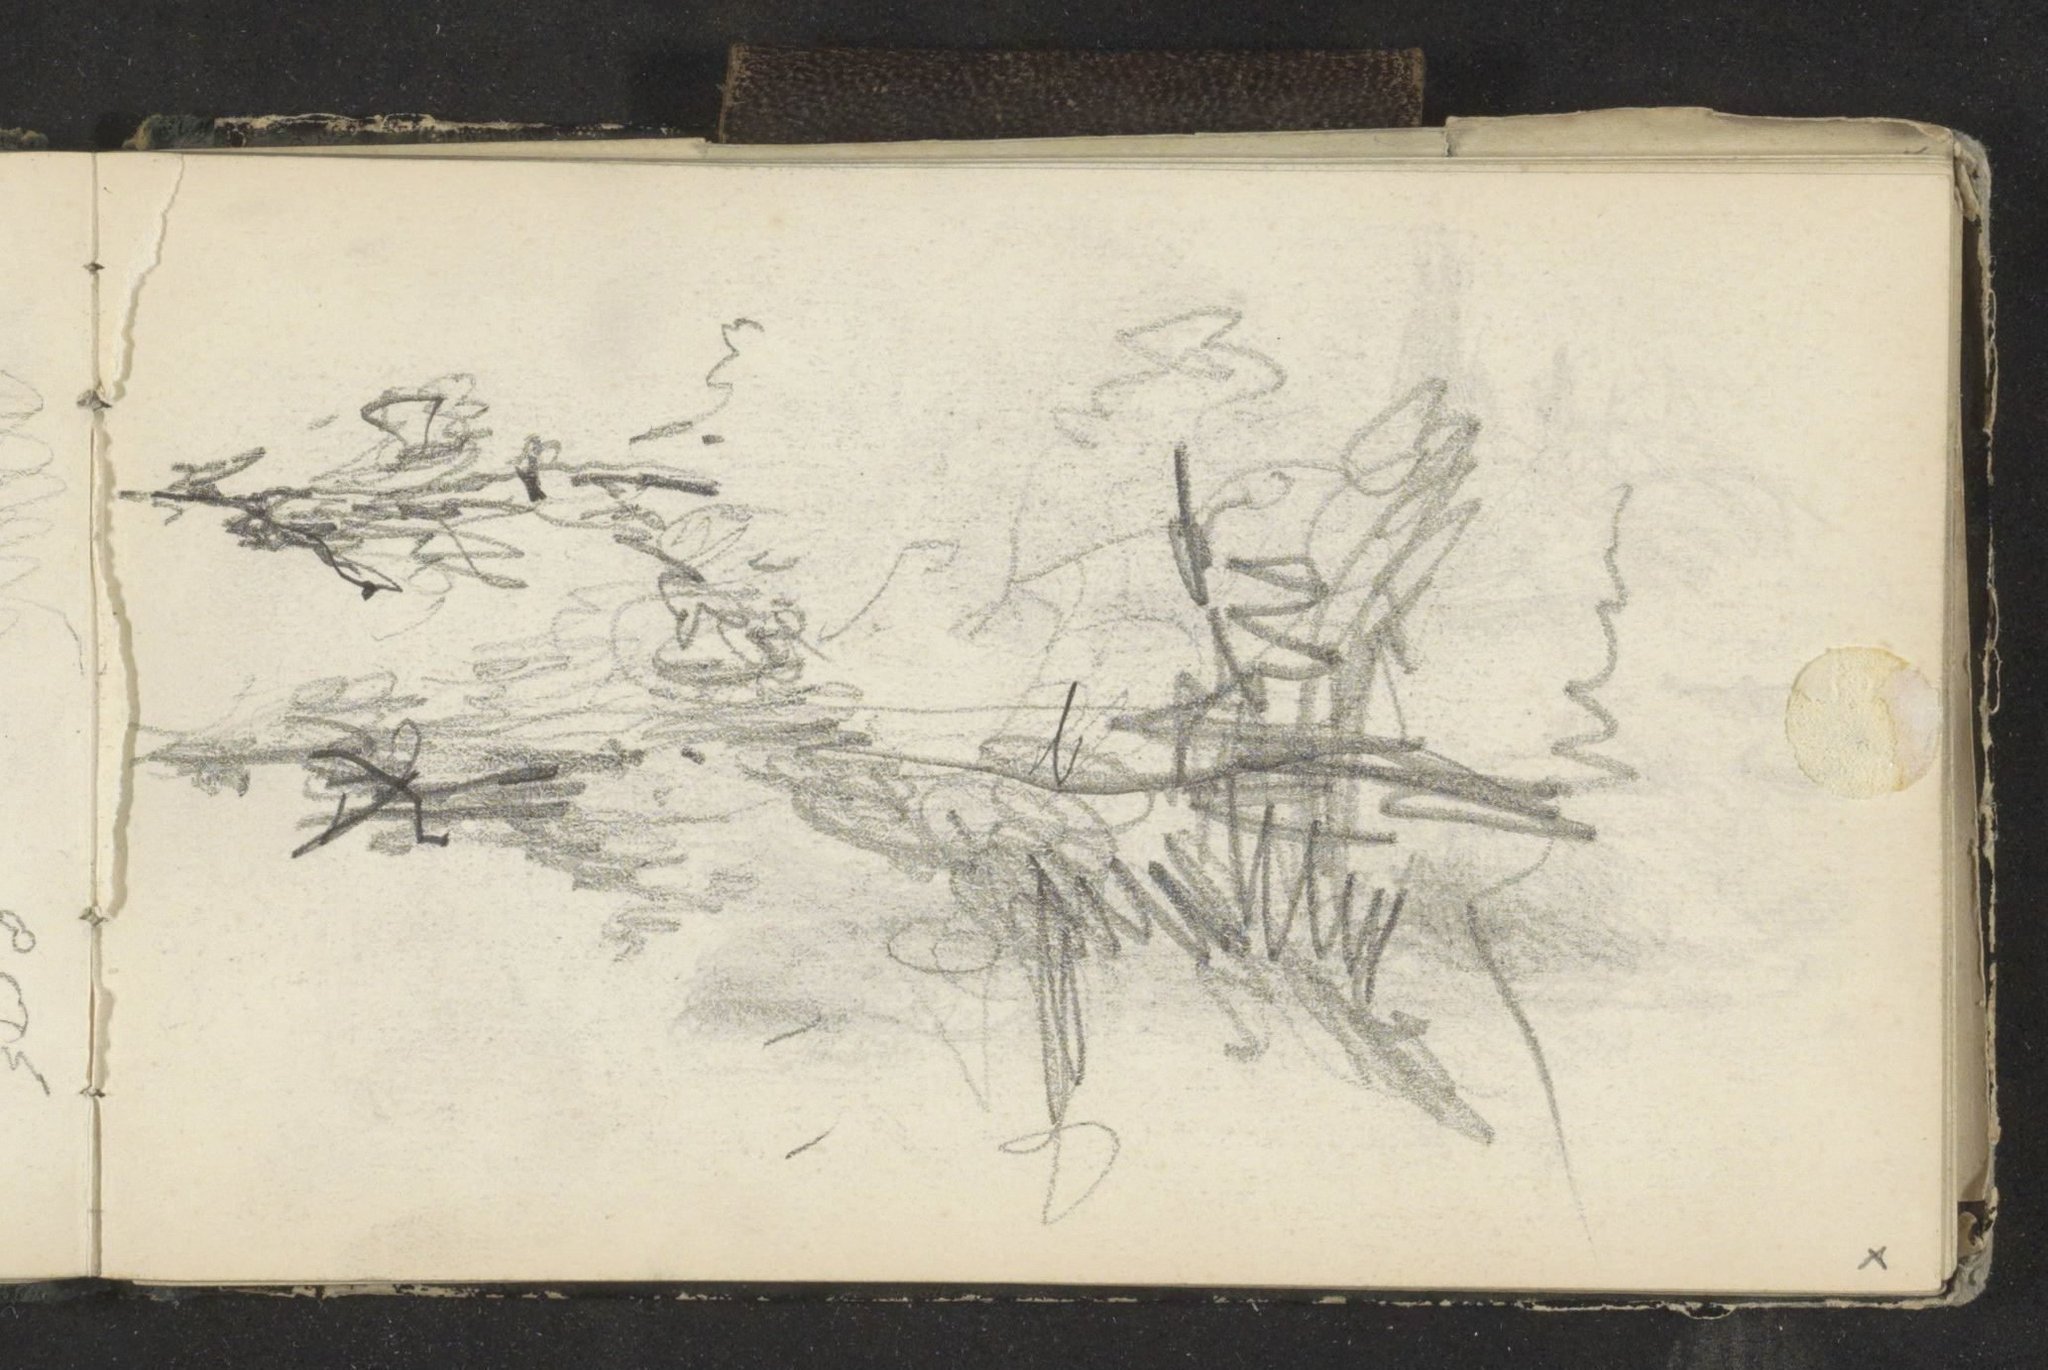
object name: sketchbook leaf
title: Bomen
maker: maria vos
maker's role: draughtsman, painter, print maker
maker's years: 1824-1906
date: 1834-1906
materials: paper, pencil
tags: trees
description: Blad 15 recto uit een schetsboek met 46 bladen.